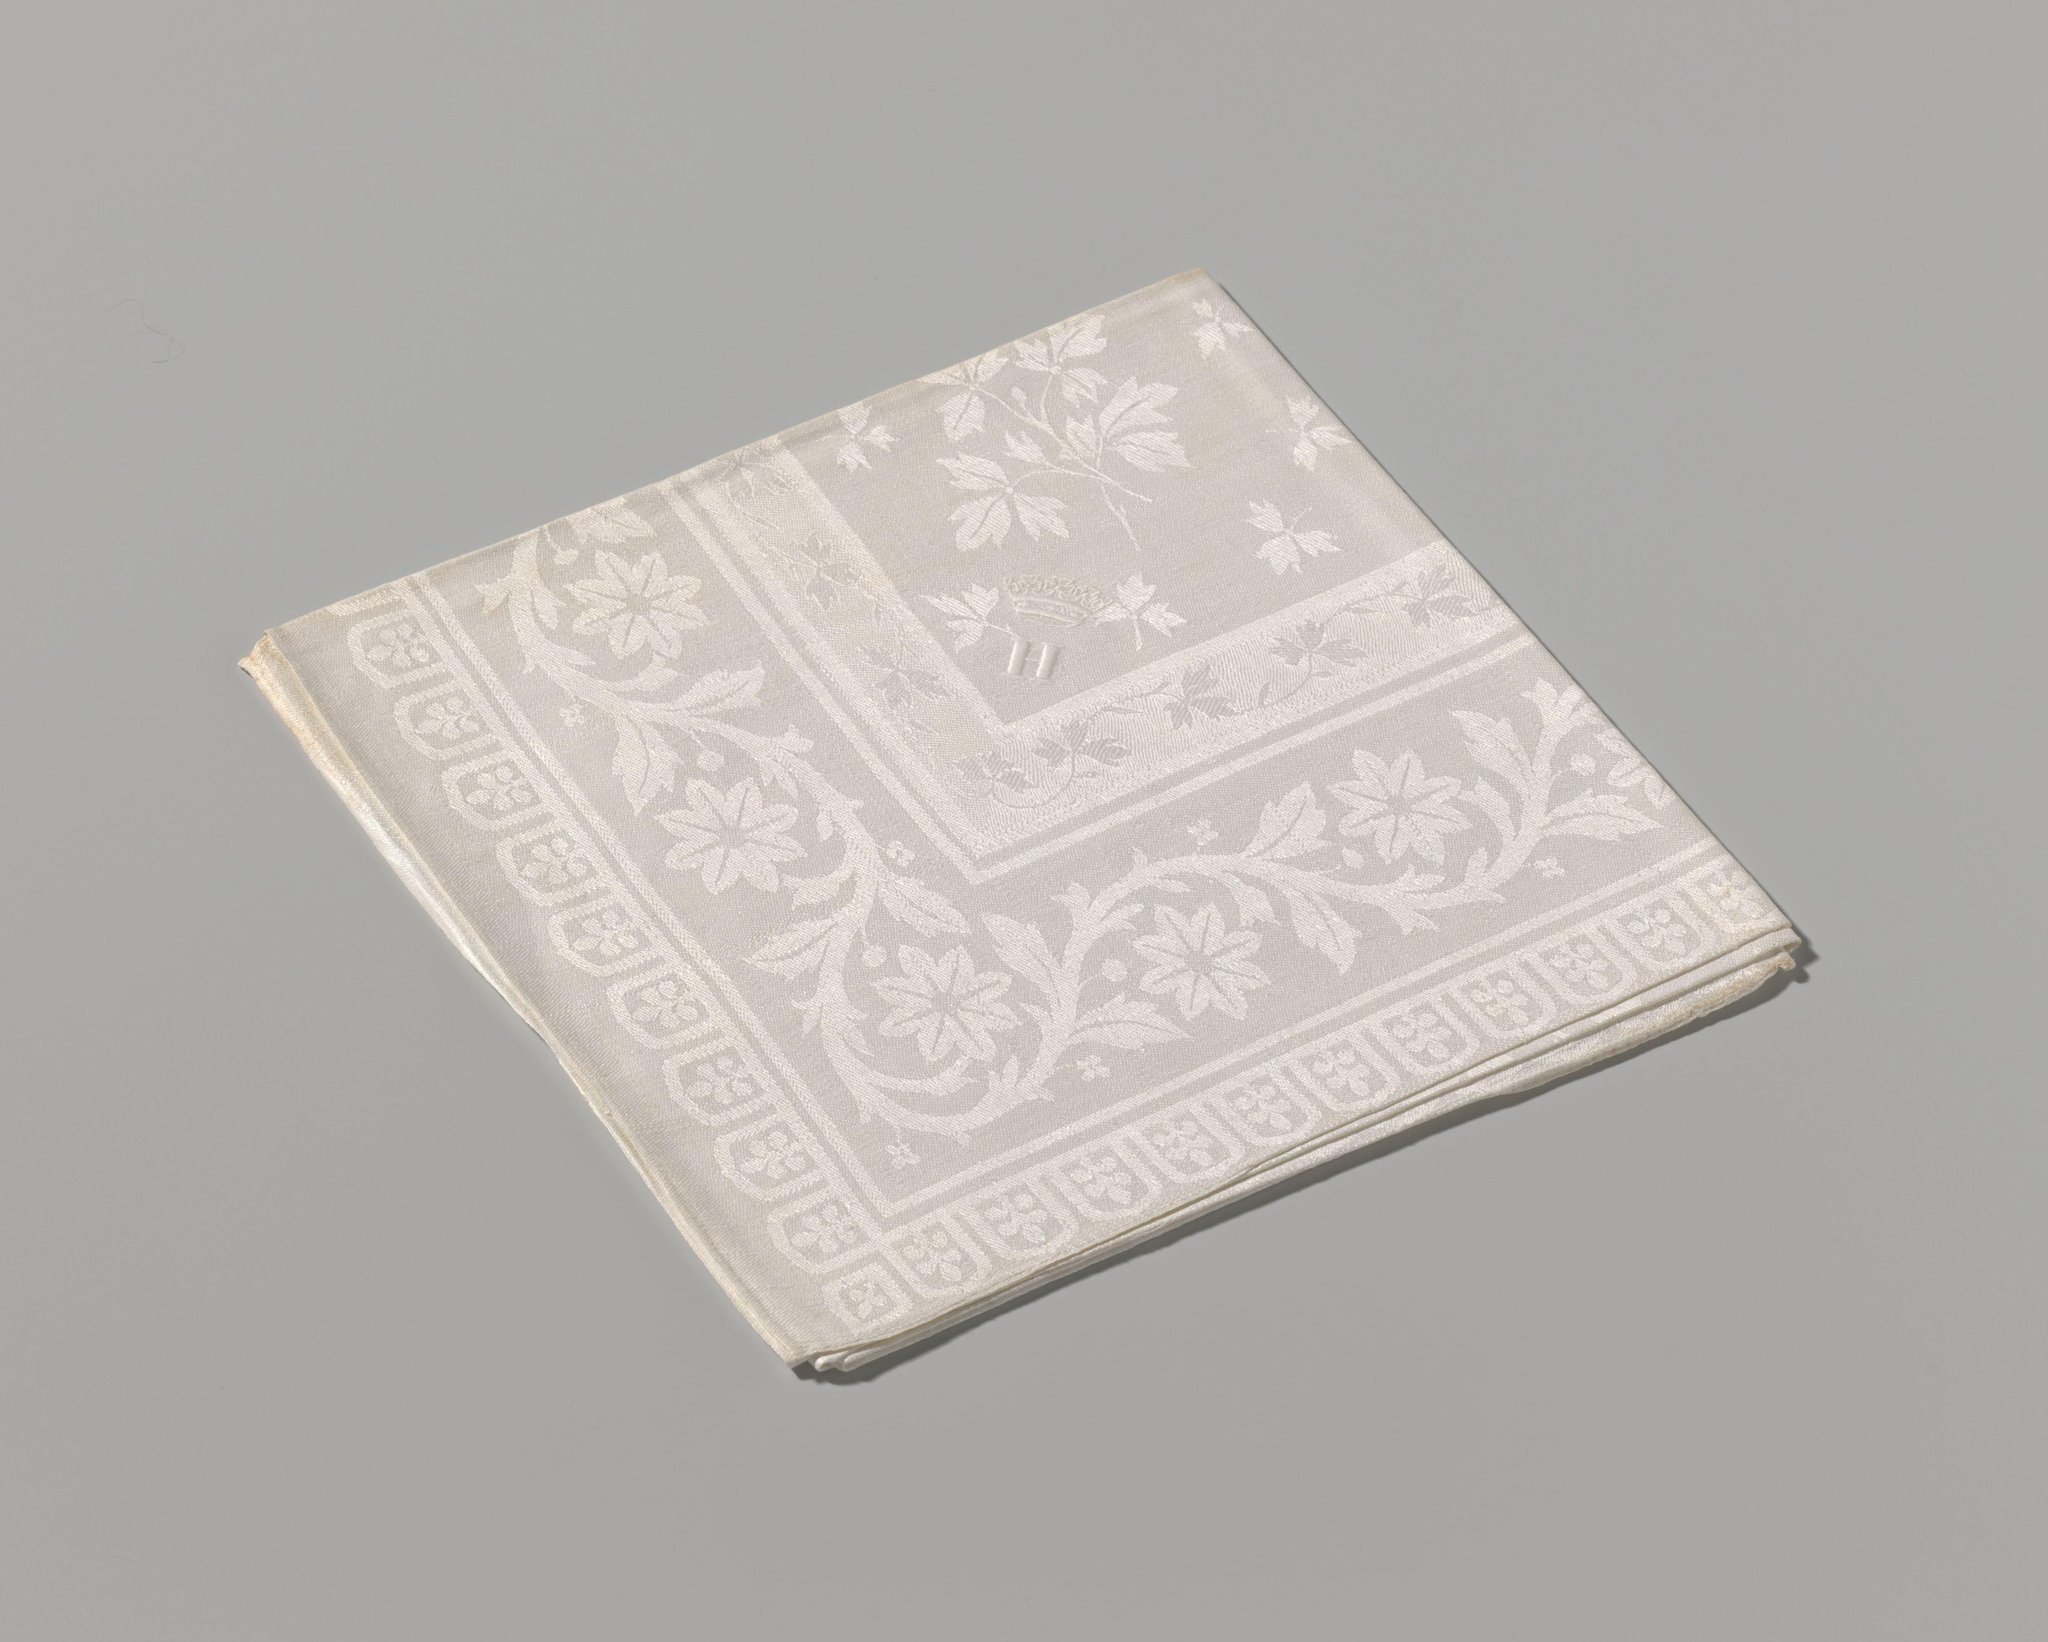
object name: napkin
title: Servet van wit linnendamast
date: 1859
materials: linen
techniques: damask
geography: borne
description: Wit linnen damasten servet met "klaverblad", merk kroon H.